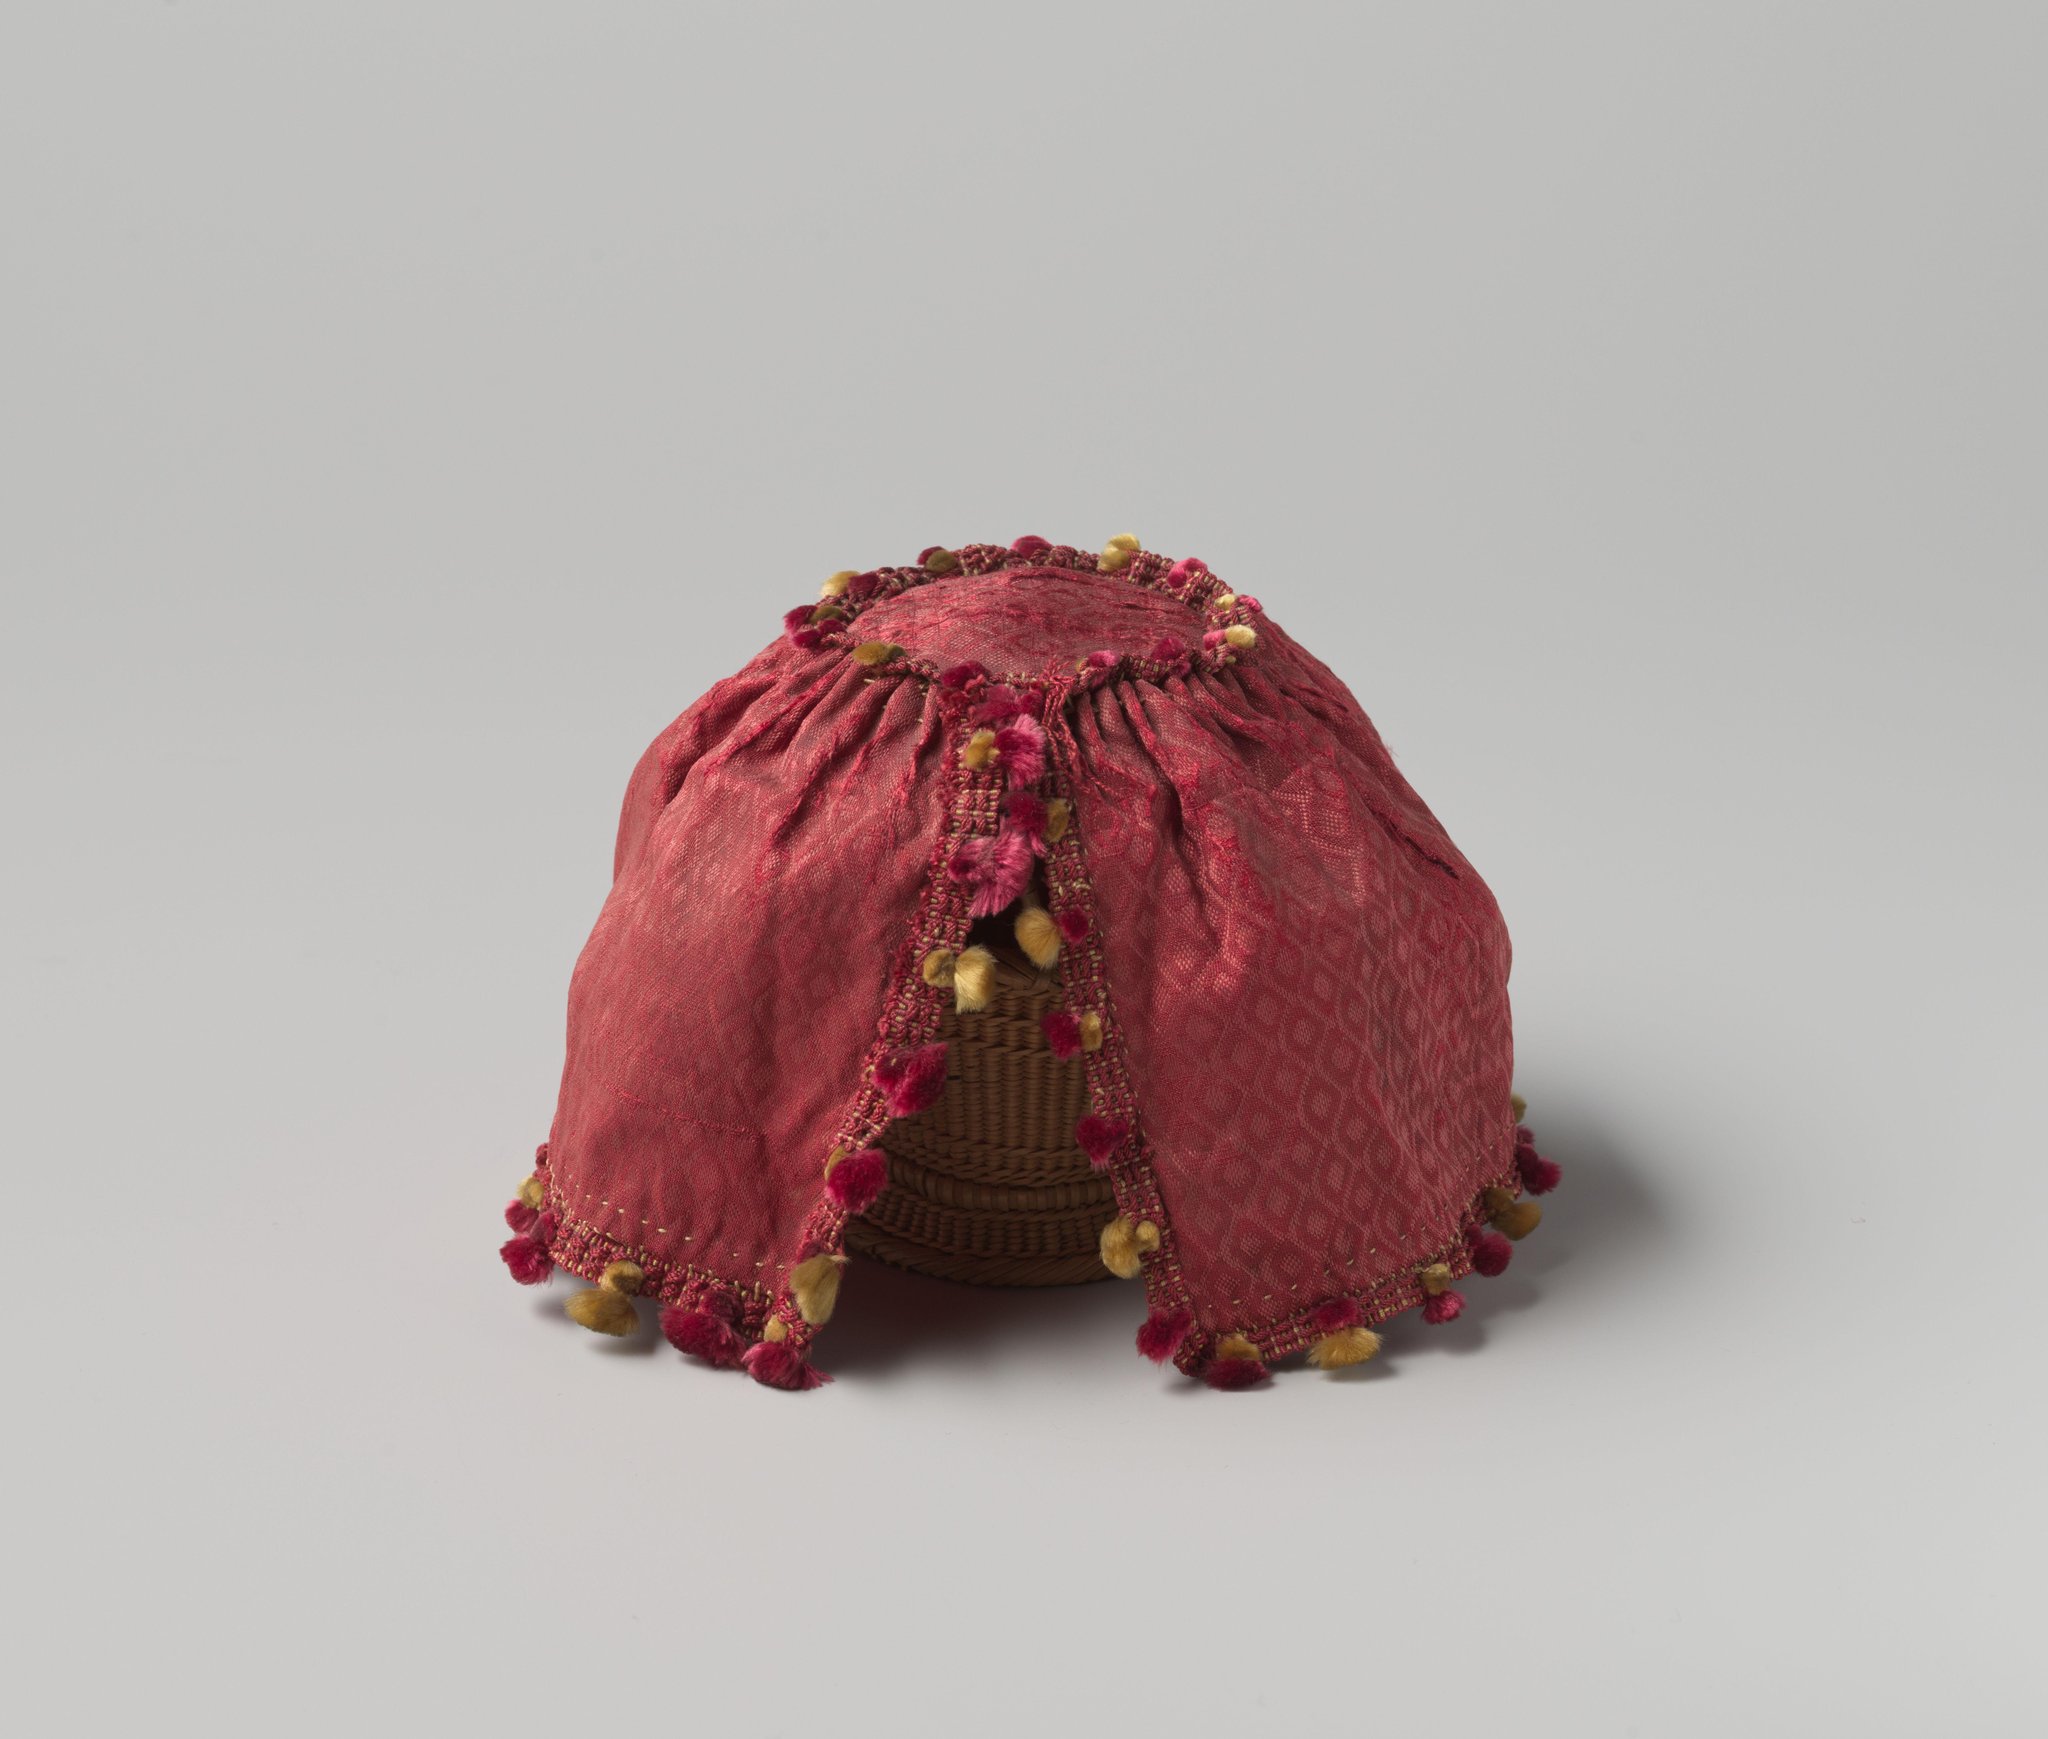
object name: miniature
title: Vuurmandkleed van rode zijde met een ingeweven ruitmotief, afgezet met passement met gele en rode kwastjes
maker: Anonymous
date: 1690-1710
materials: silk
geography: amsterdam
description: Vuurmandkleed van rode zijde met een ingeweven ruitmotief, afgezet met passement, afwisselend met gele en rode kwastjes; de bolvormige constructie bestaat uit een rond bovenvlak, waaraan een brede afhangende strook is aangerimpeld, waarvan de uiteinde niet aan elkaar zijn genaaid.